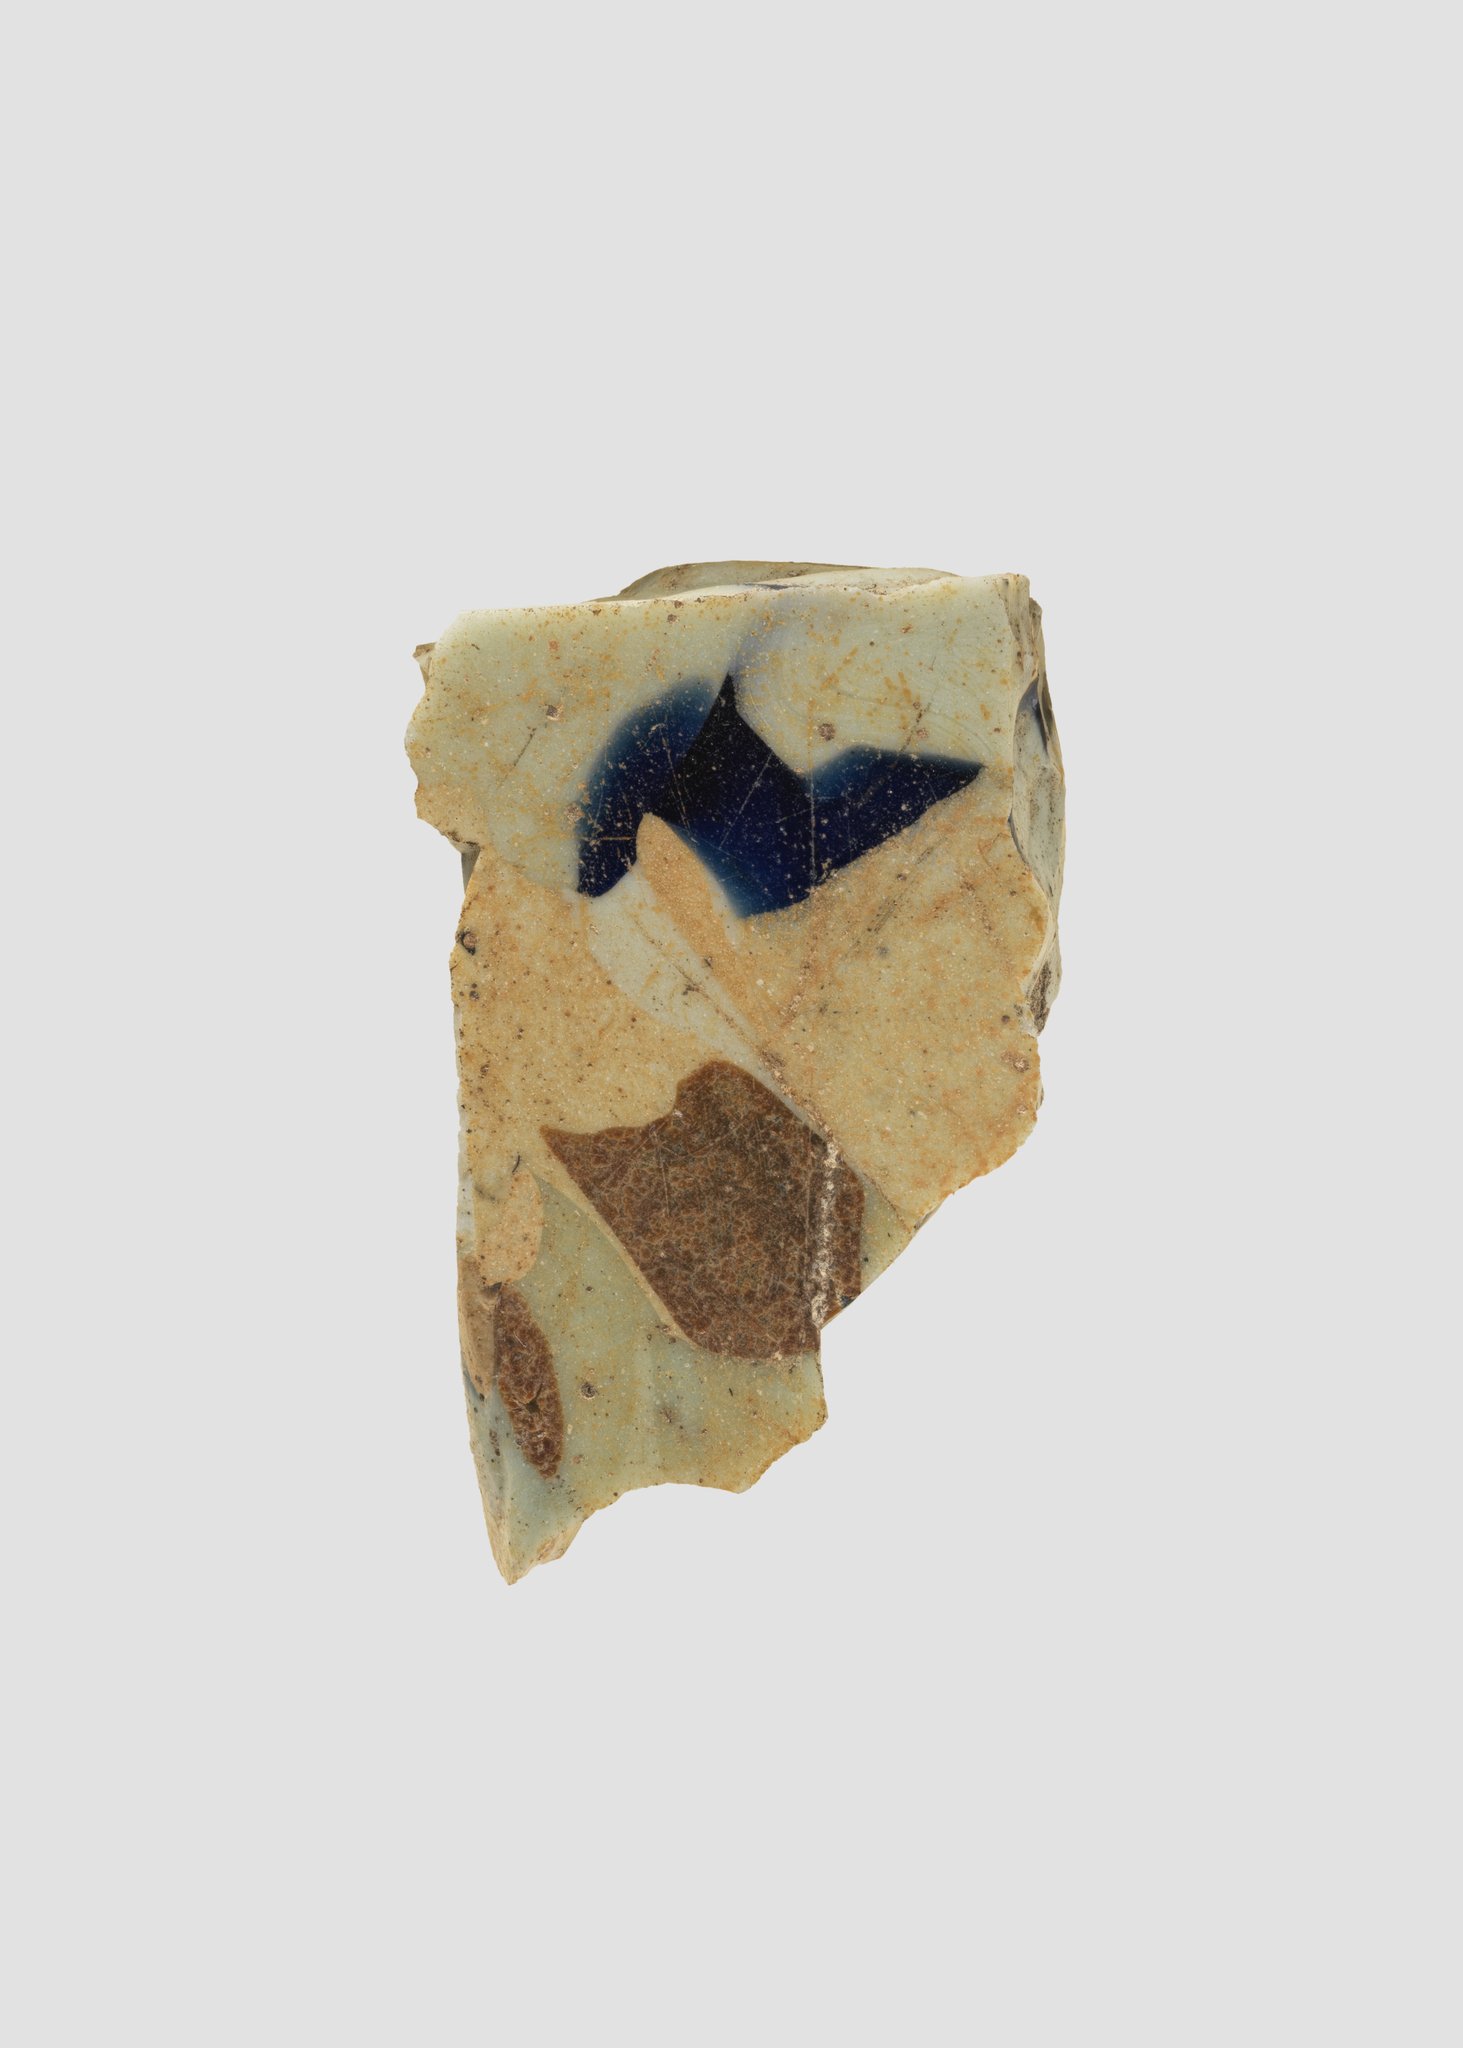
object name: plaque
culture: sasanian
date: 201-700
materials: glass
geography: mesopotamia